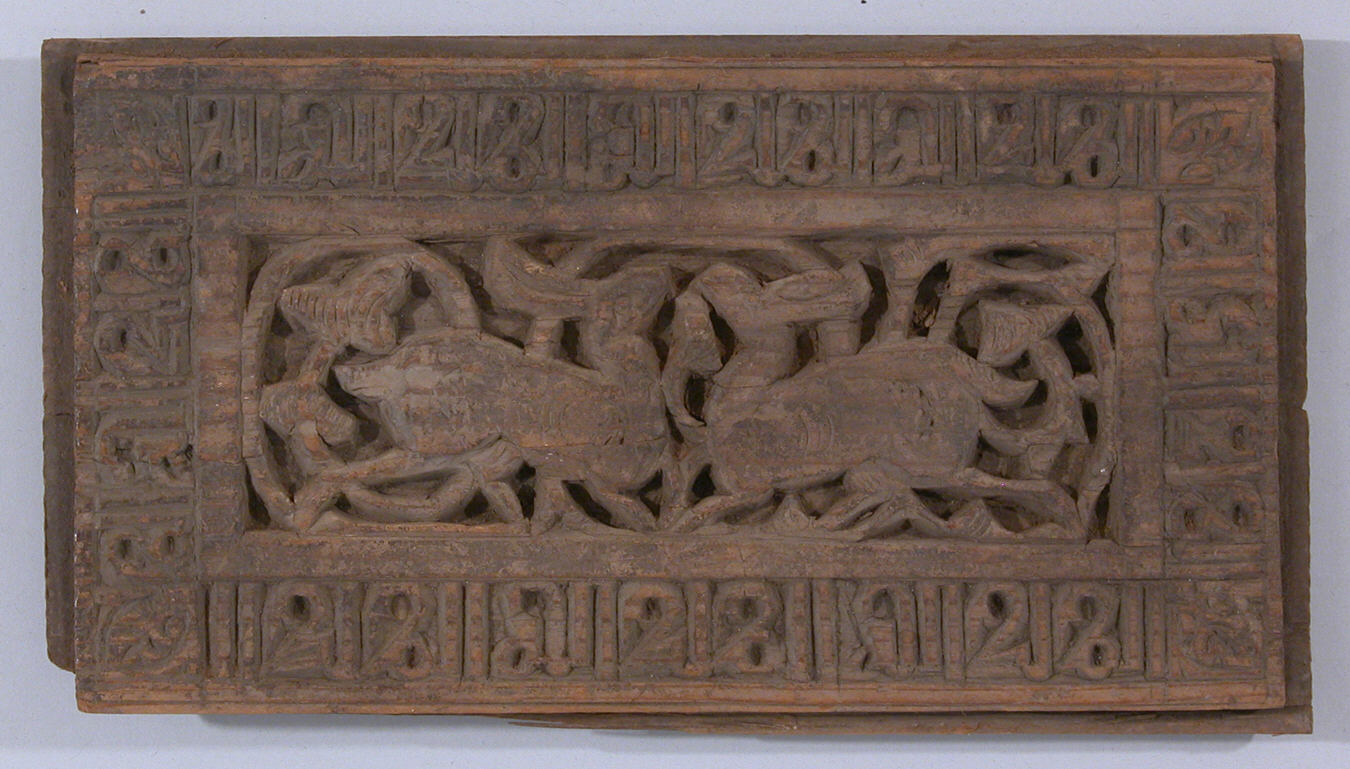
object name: panel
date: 1001-1100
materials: wood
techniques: carving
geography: egypt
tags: animals